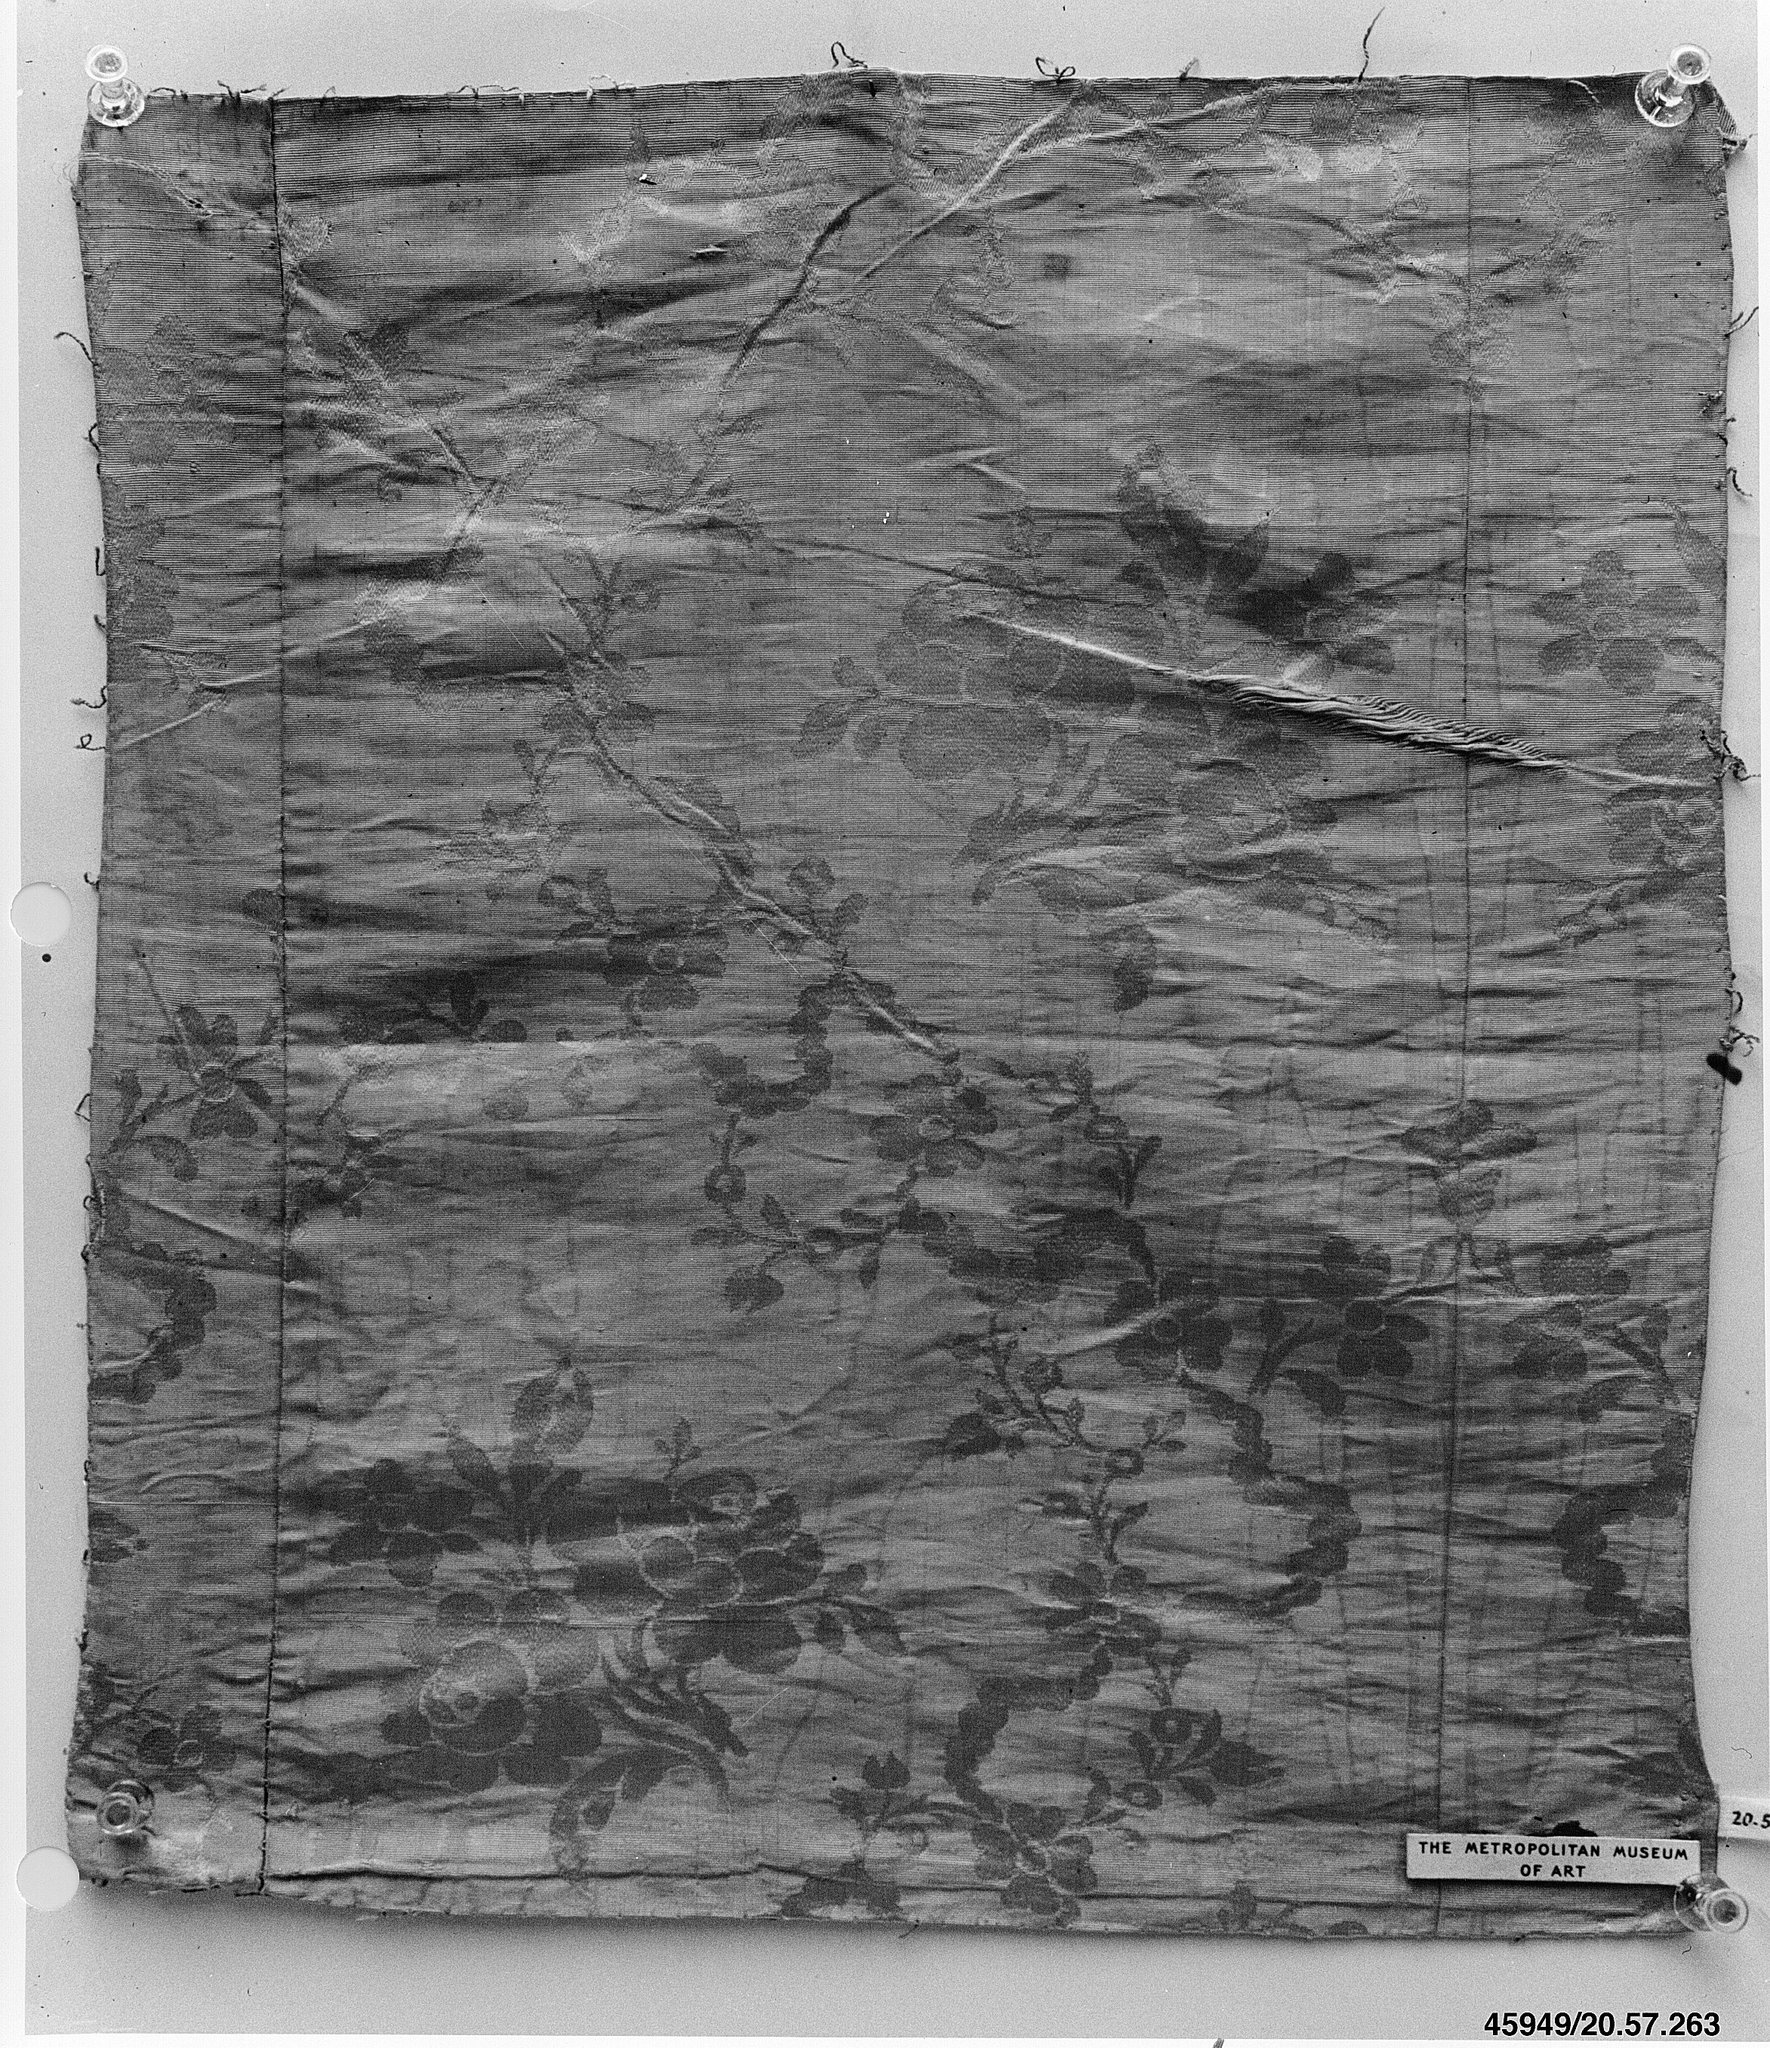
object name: piece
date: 1750-1760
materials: silk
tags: flowers,leaves